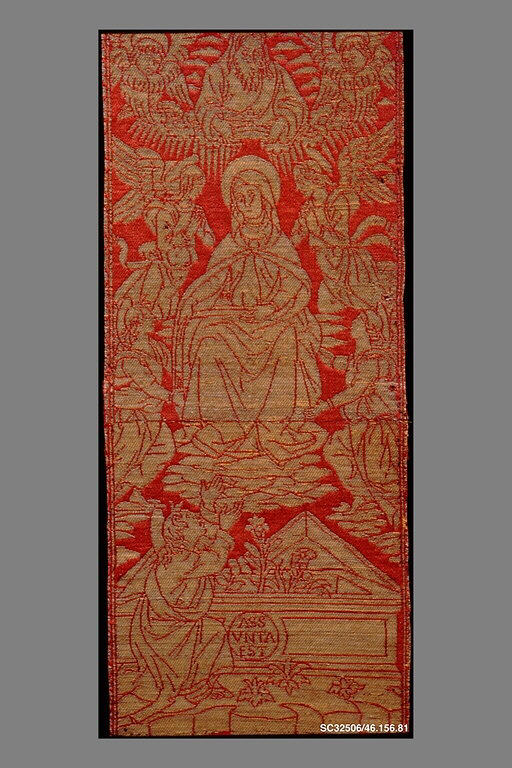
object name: orphrey fragment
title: Part of an orphrey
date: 1467-1533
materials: linen, metal thread, silk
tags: angels,assumption of the virgin